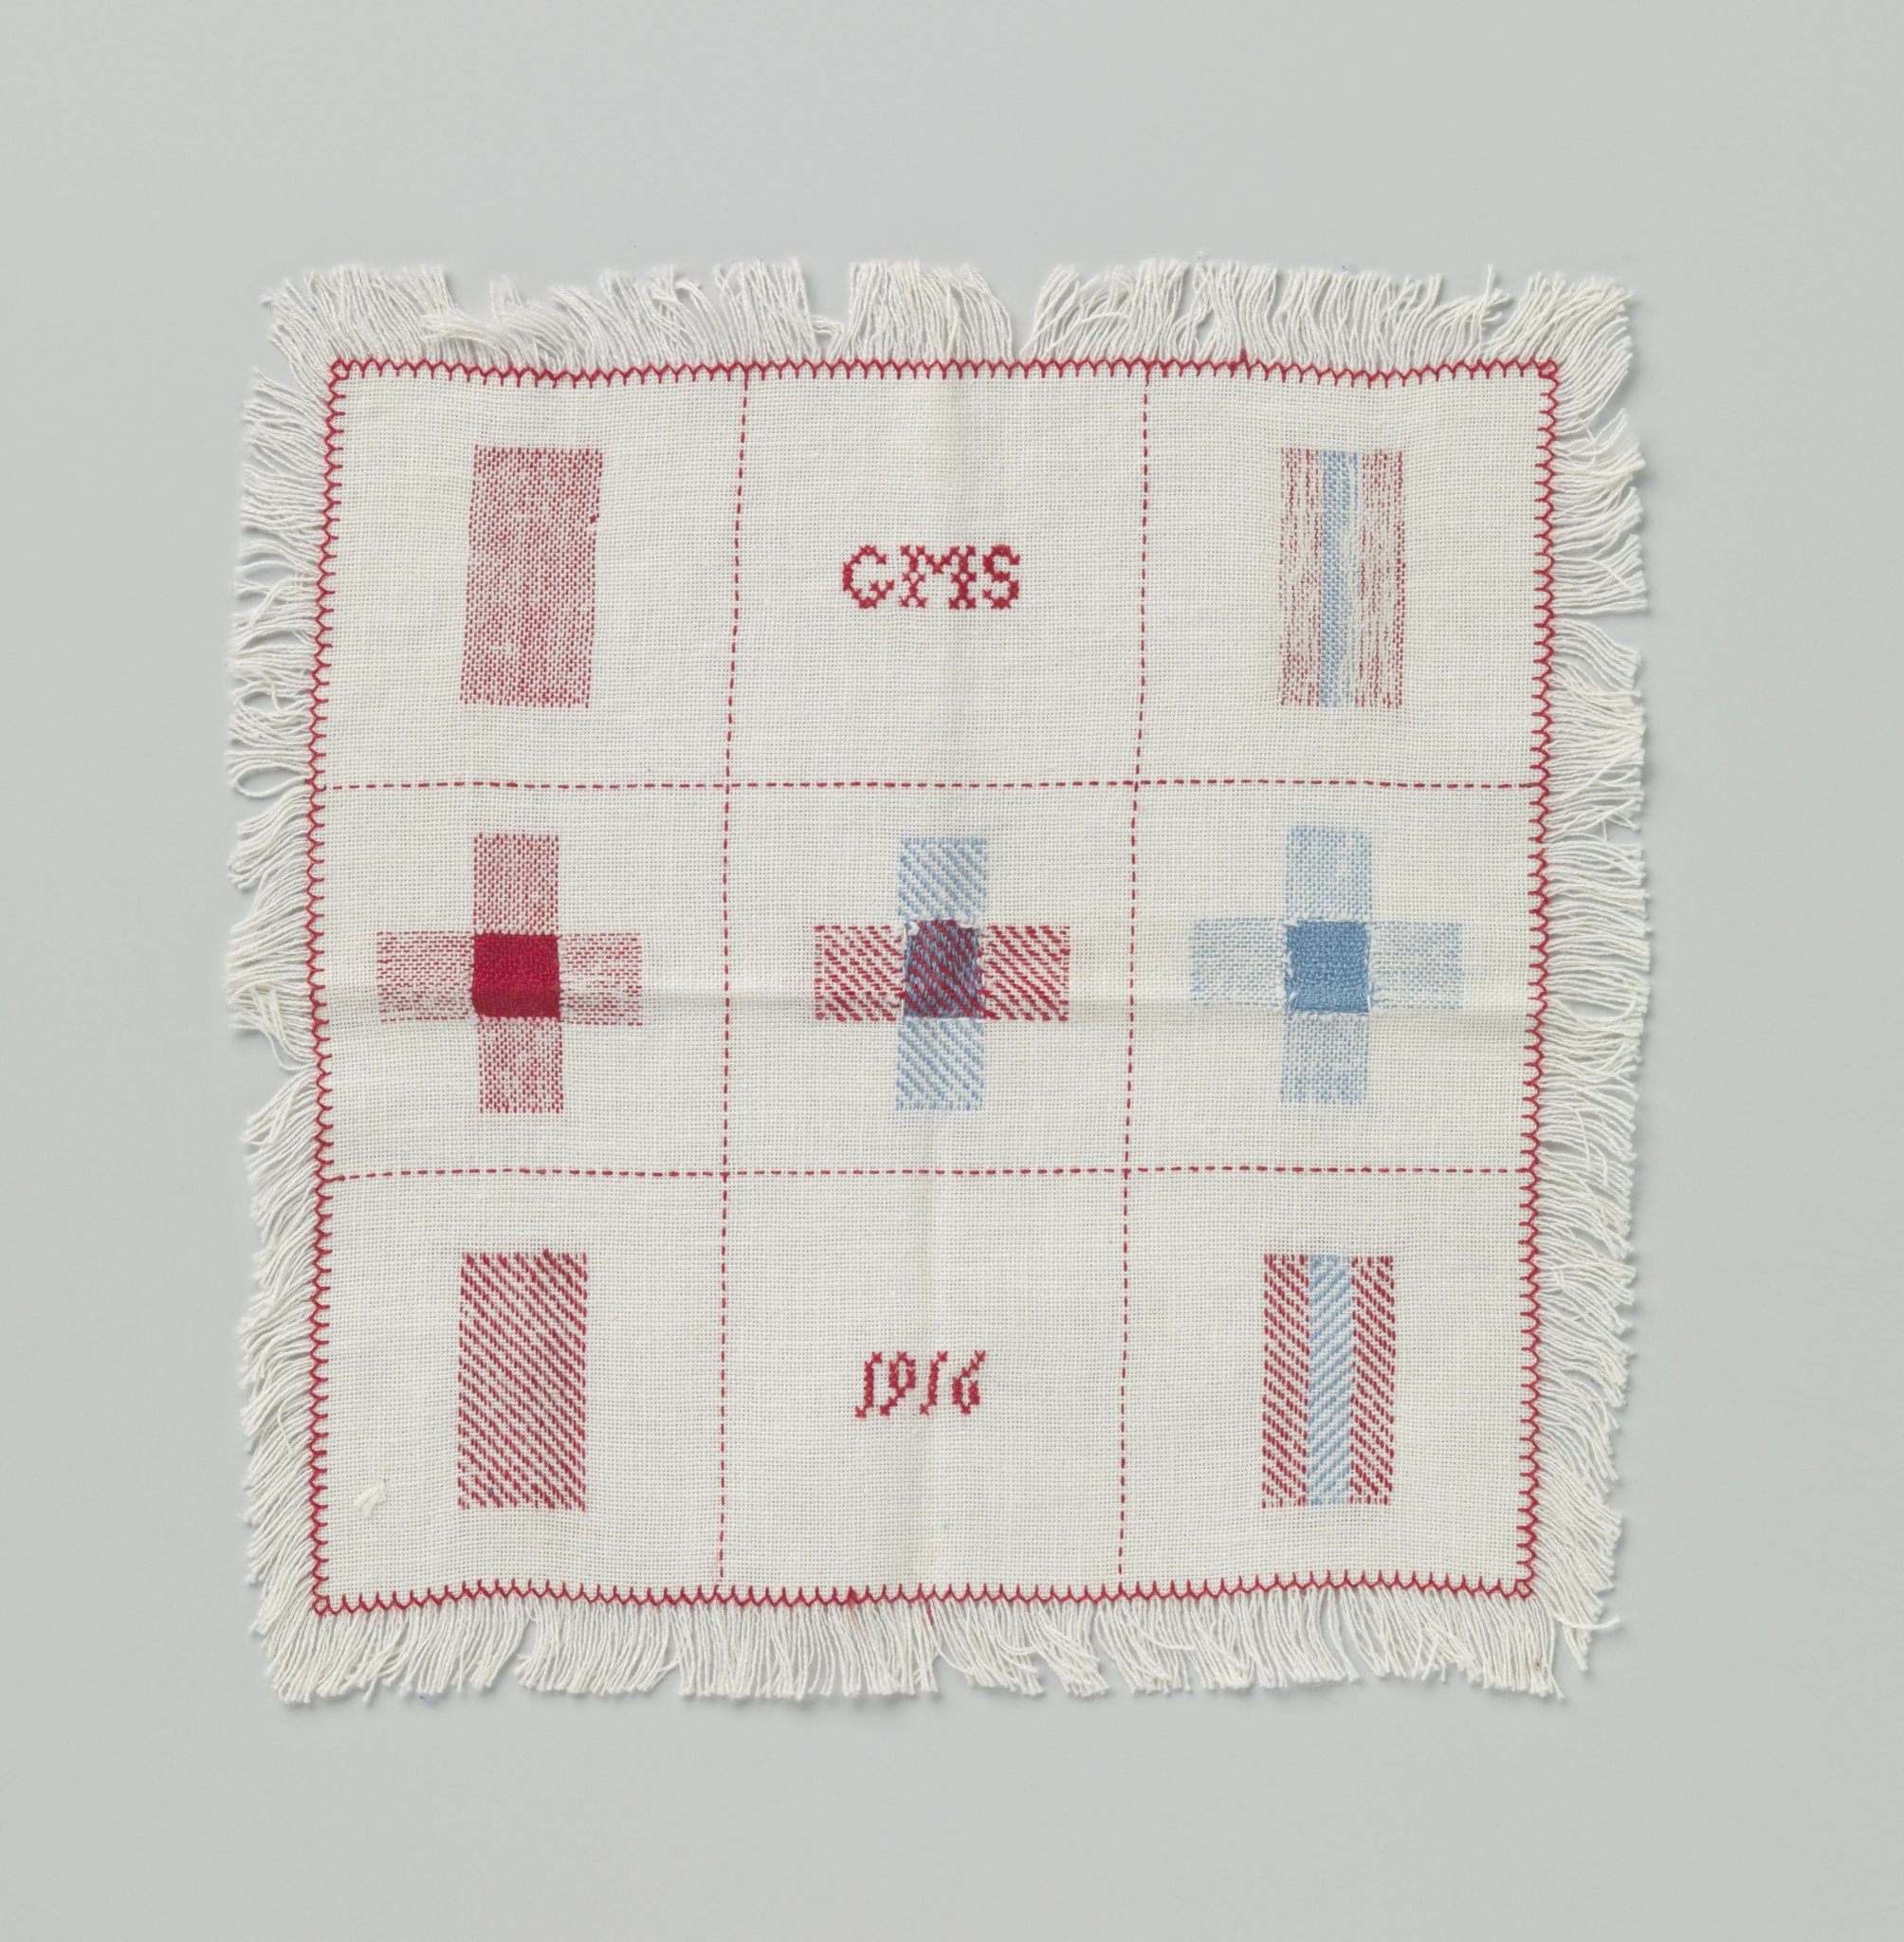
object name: stoplap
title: Stoplap van veelkleurige katoen op katoen.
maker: h.m. de swart-van akkeren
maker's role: borduurster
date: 1916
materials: cotton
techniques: embroidered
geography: amsterdam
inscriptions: date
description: Stoplap van katoen op katoen. Het borduurwerk heeft de initialen GMS, het jaartal 1916 en diverse stoppen.